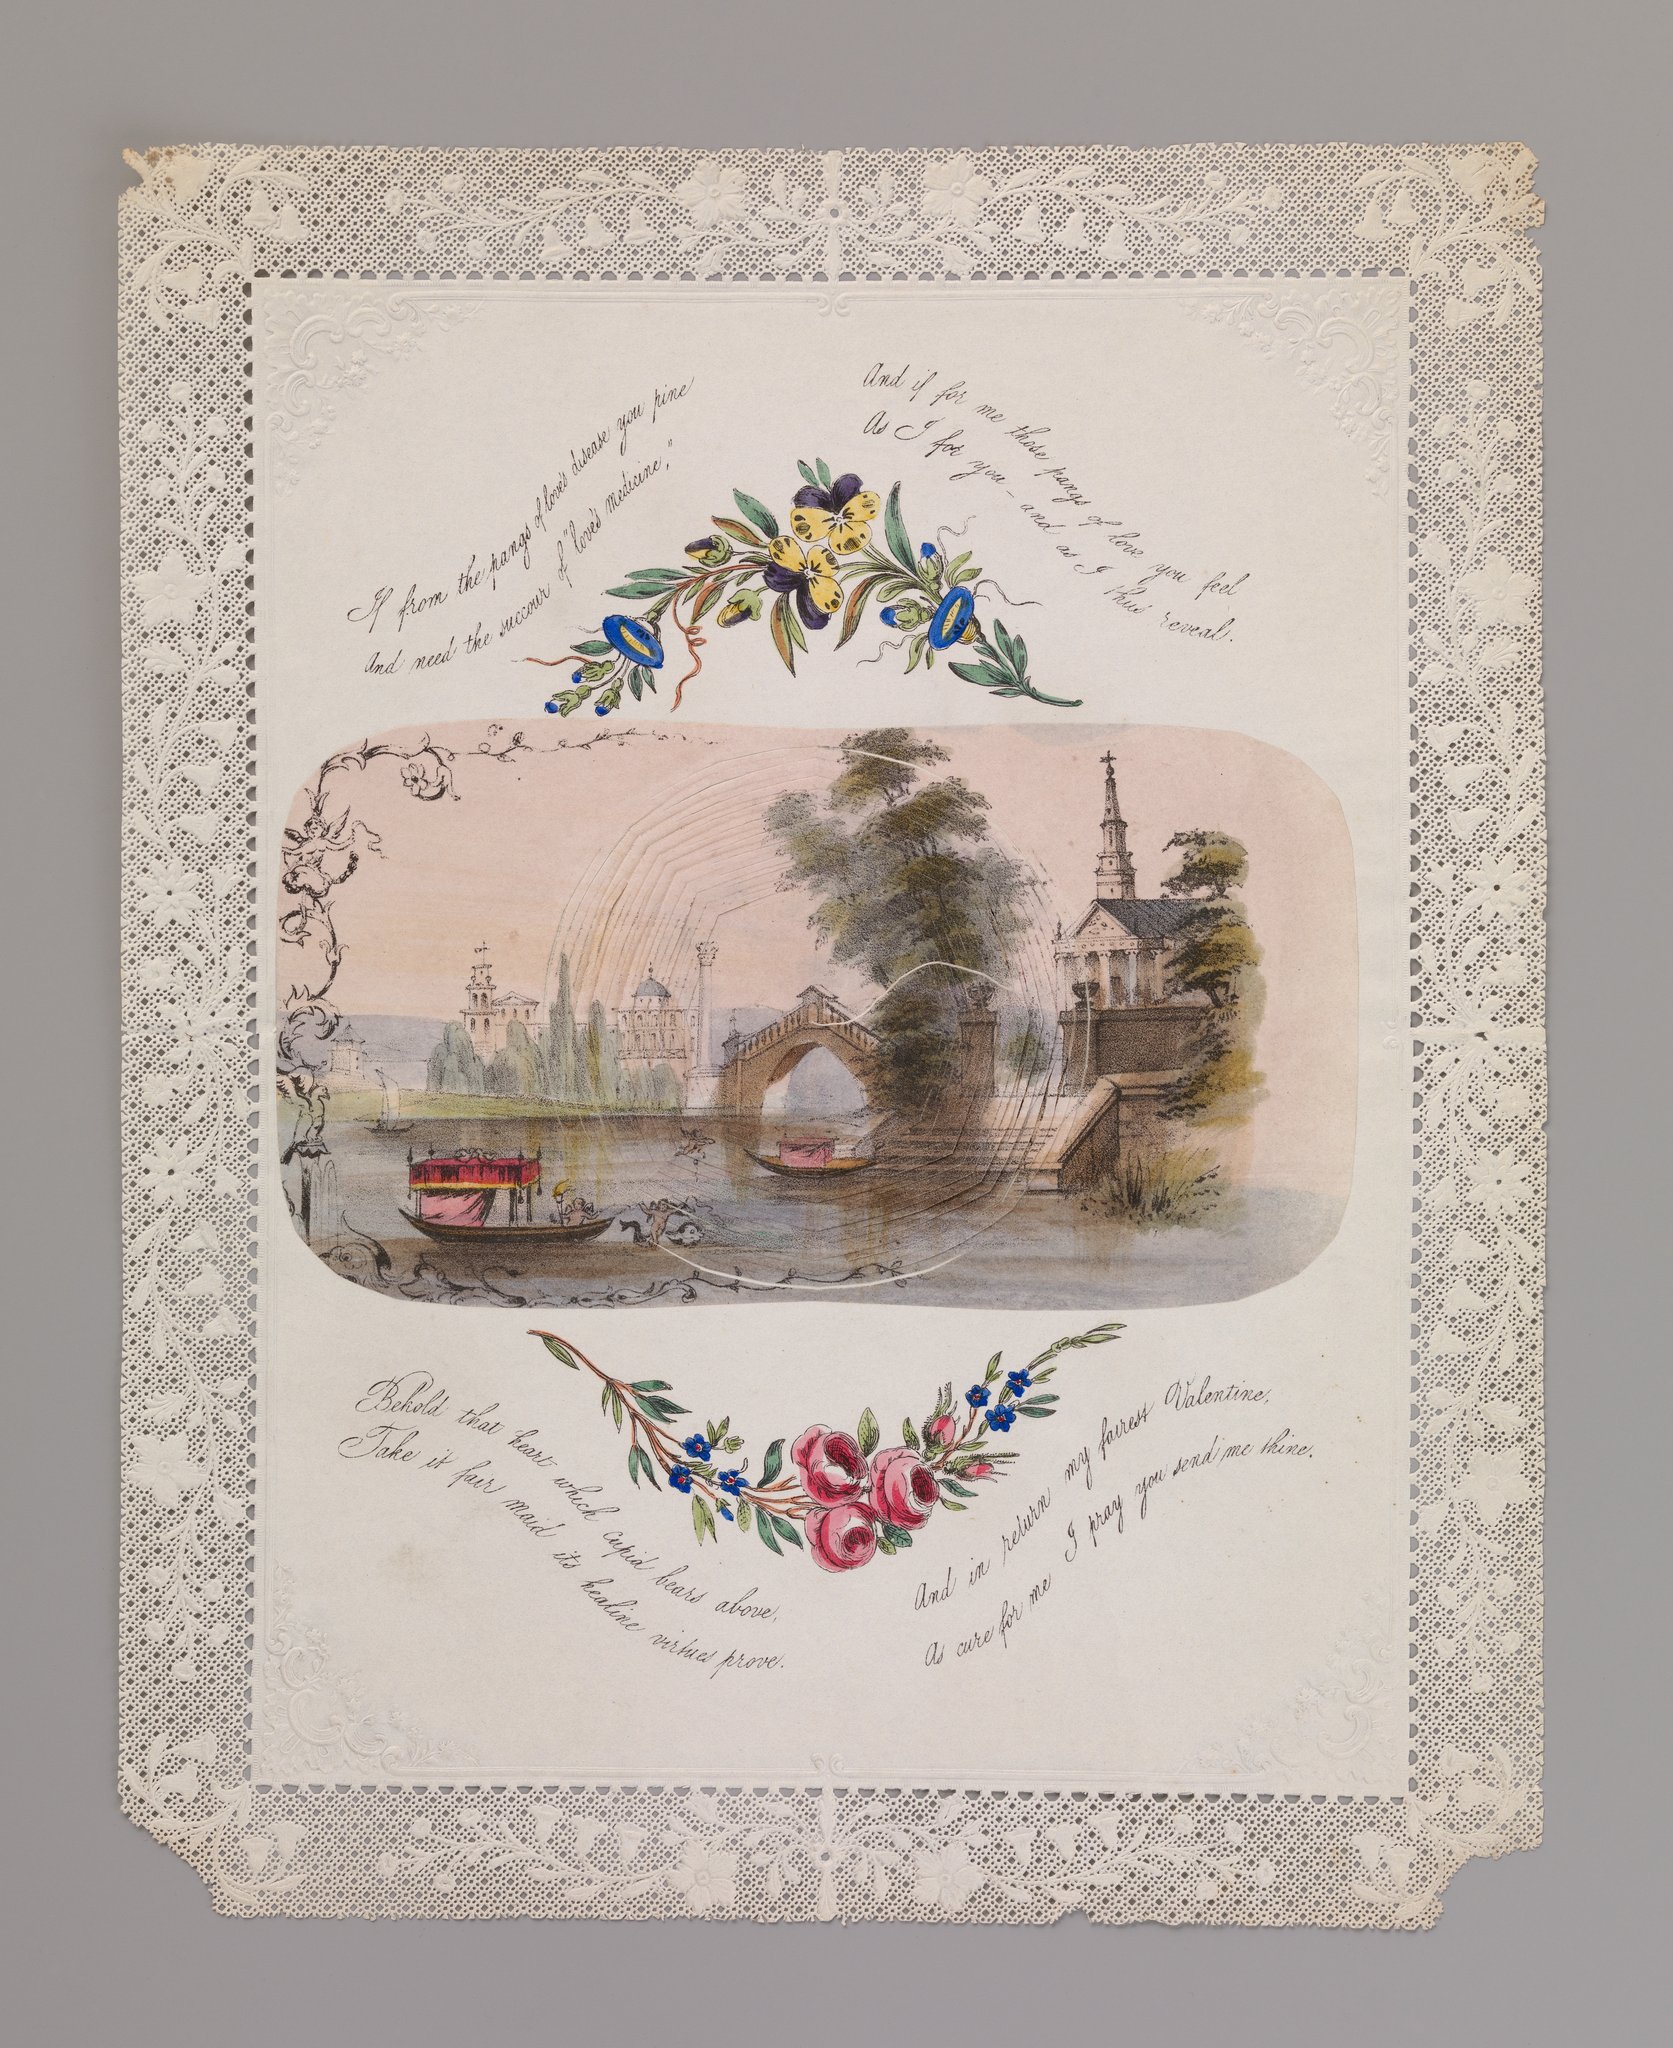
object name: valentine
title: Double cobweb valentine with Venetian scene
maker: Anonymous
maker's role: artist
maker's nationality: british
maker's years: 1800-1899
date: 1830-1850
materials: paper, watercolor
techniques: embossing, lithograph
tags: buildings,flowers,trees,boats